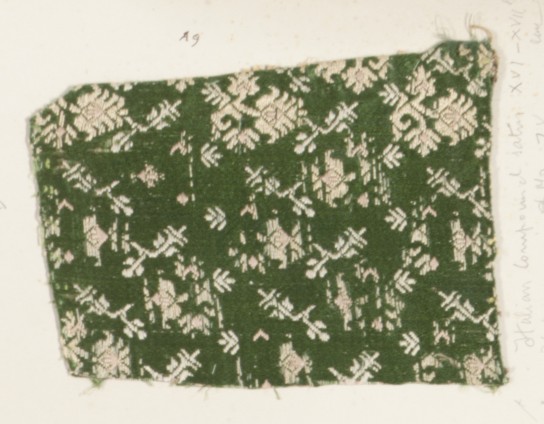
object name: fragment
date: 1501-1700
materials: silk